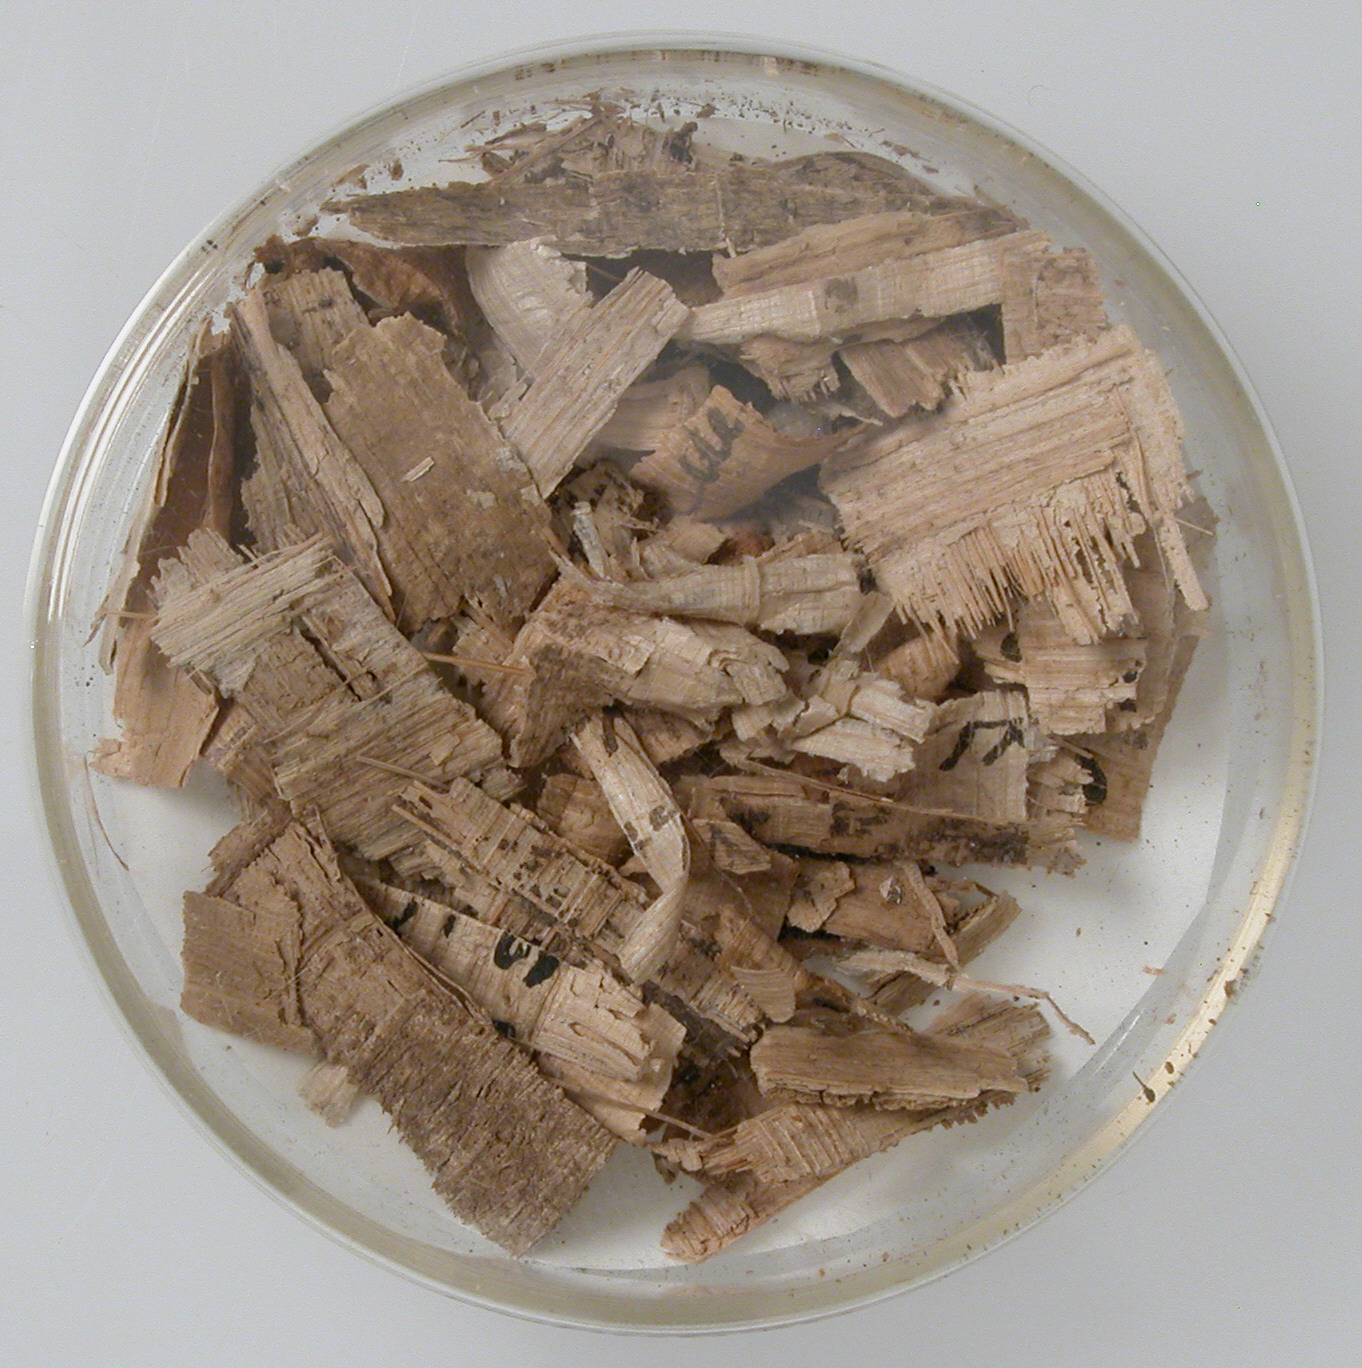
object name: fragment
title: Papyri Fragments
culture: coptic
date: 601-700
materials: ink, papyrus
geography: egypt